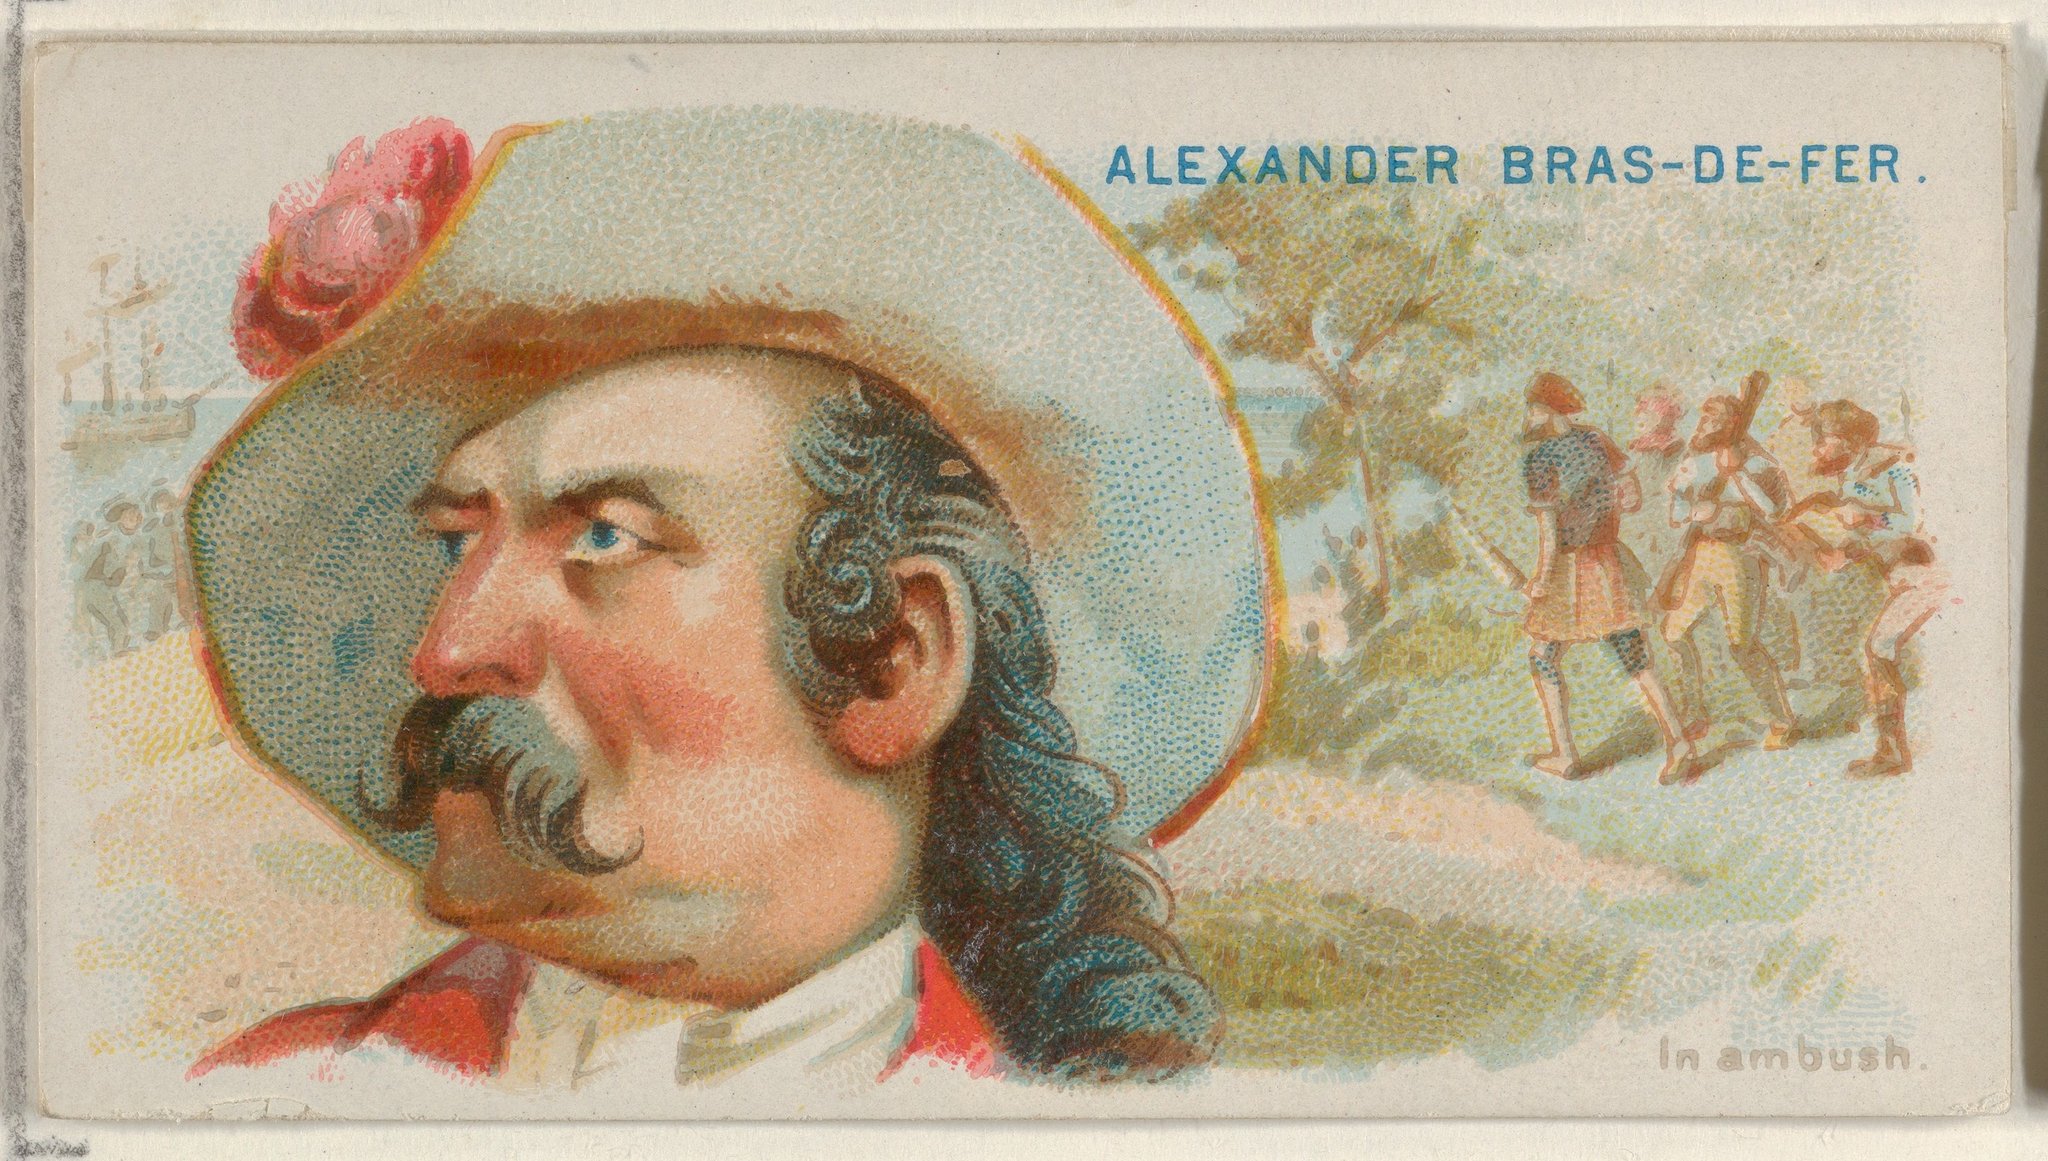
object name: print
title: Alexander Bras-de-Fer, In Ambush, from the Pirates of the Spanish Main series (N19) for Allen & Ginter Cigarettes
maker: allen & ginter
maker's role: publisher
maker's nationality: american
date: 1888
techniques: color lithograph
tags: men